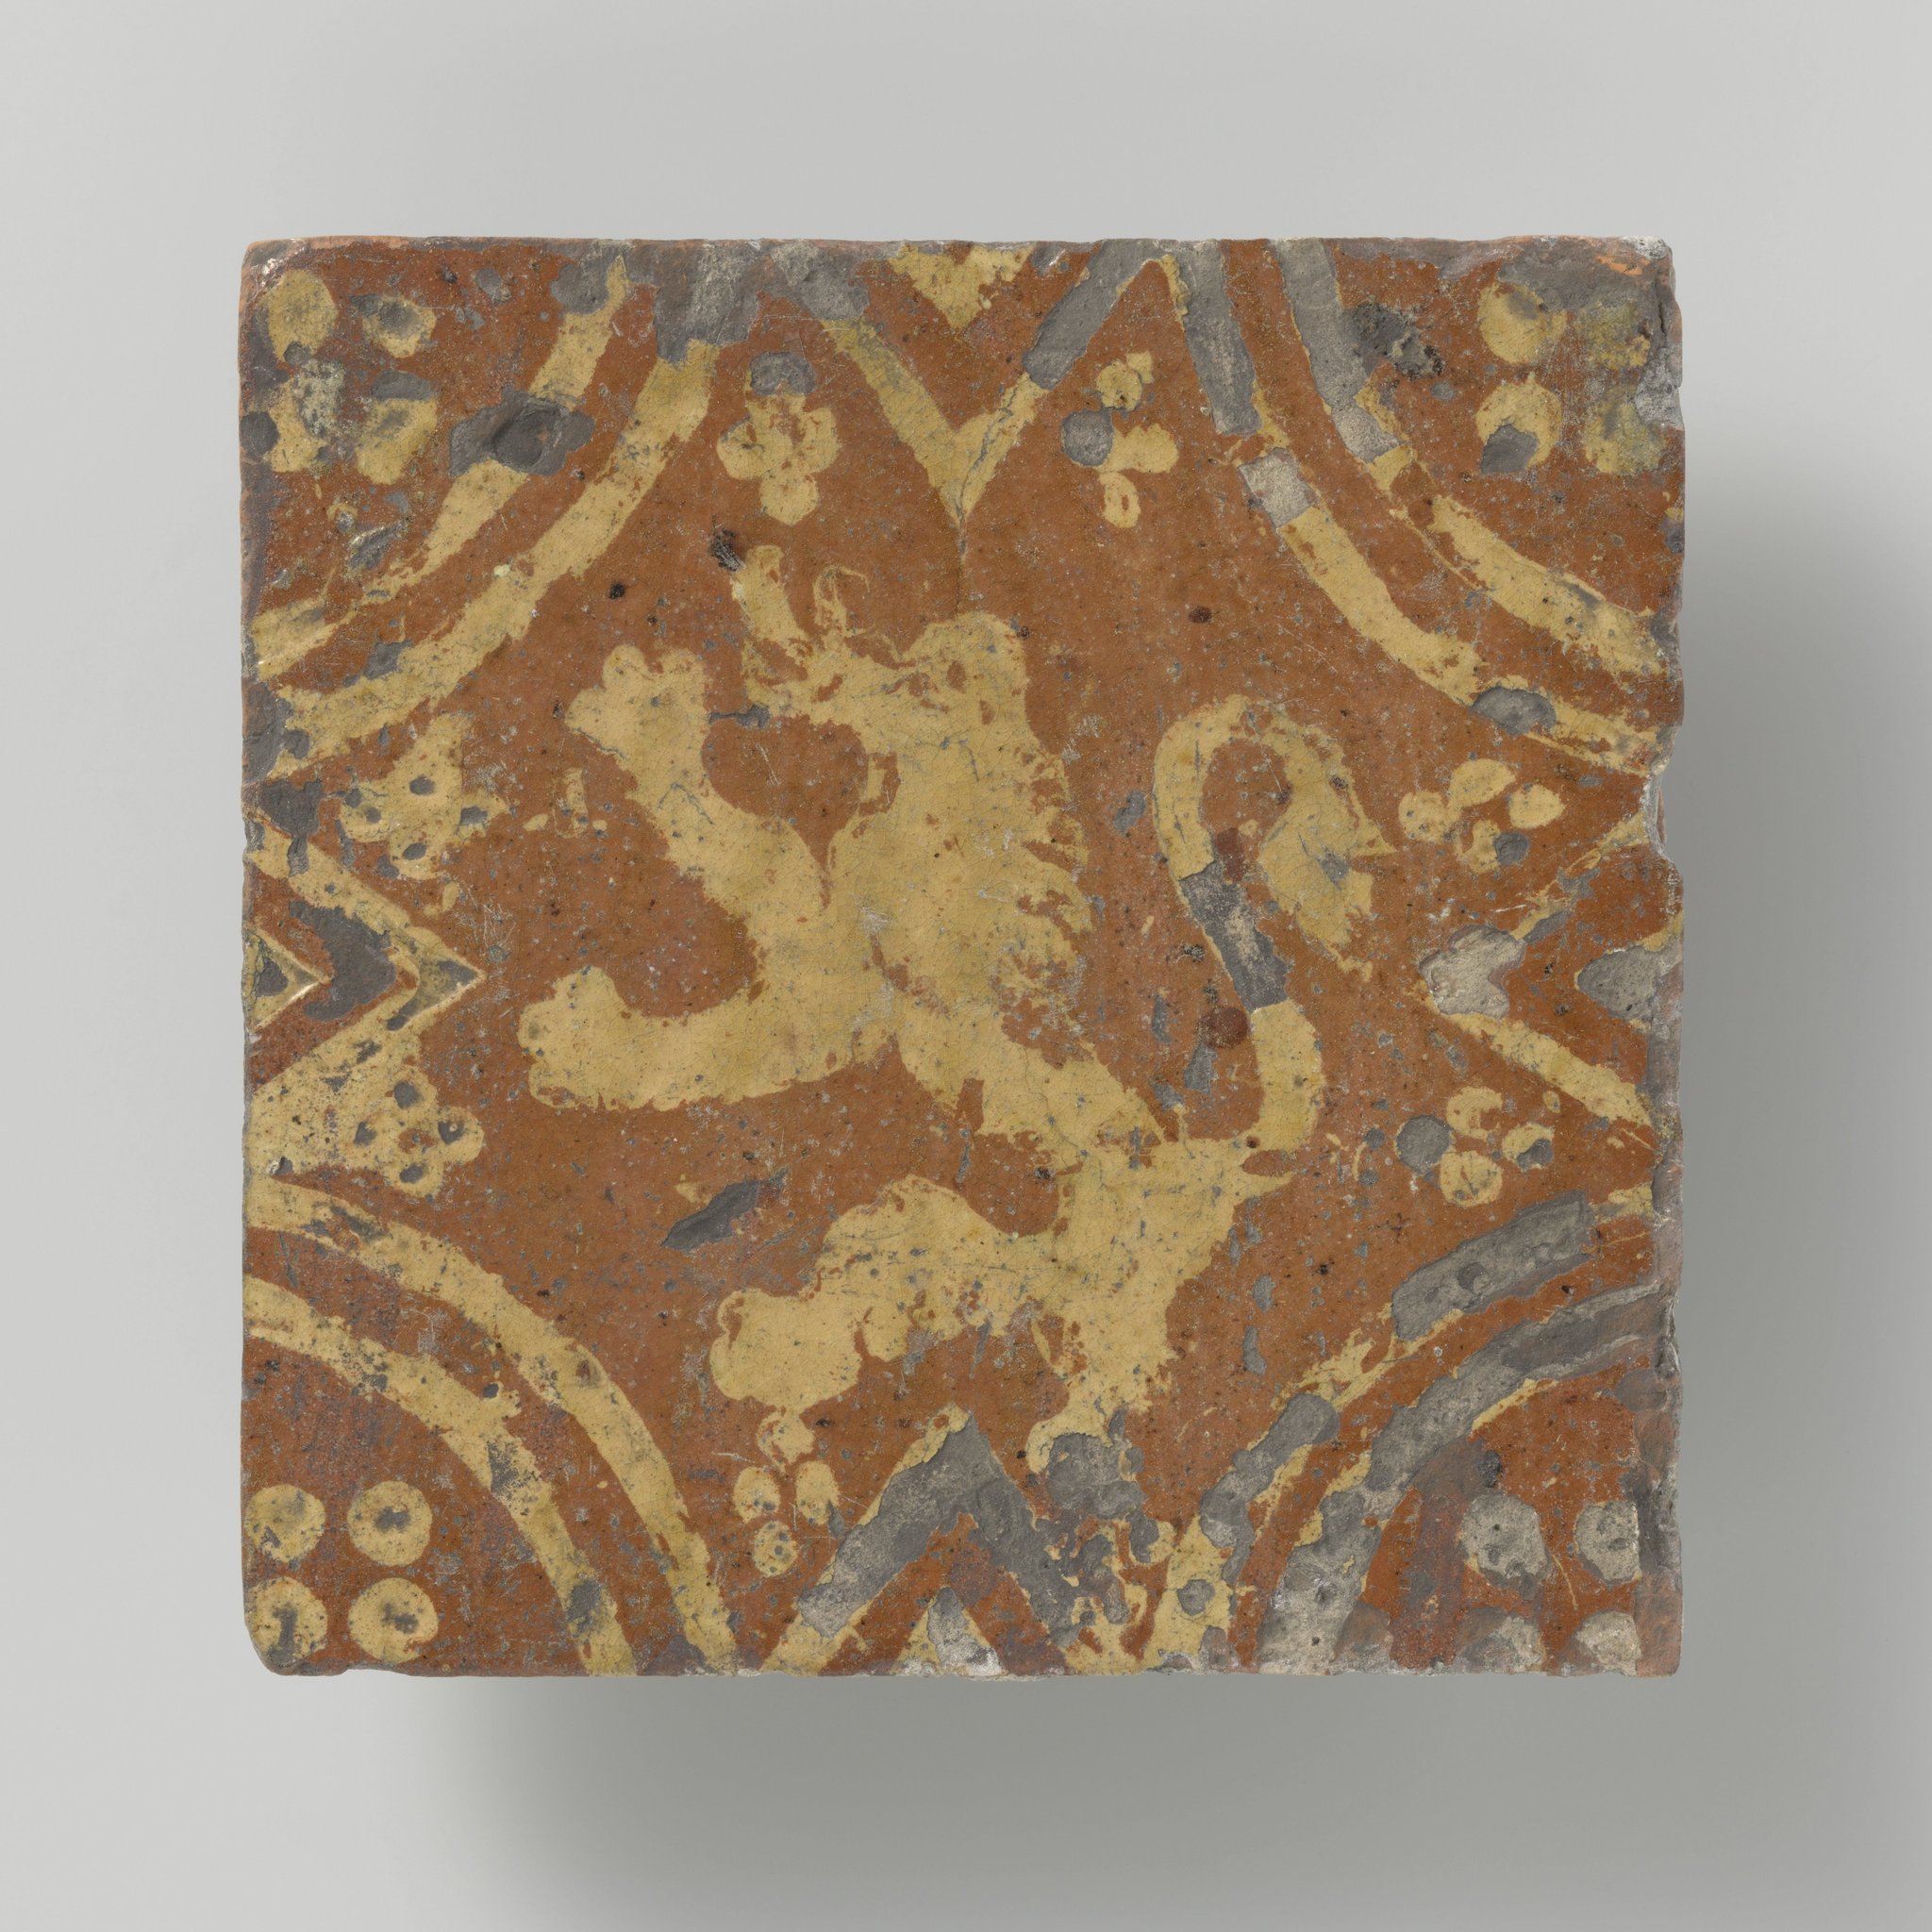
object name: tile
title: Tegel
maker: Anonymous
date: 1700-1800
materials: earthenware, glaze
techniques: maiolica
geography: tunisia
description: Tegel beschilderd in geel met een klimmende leeuw.